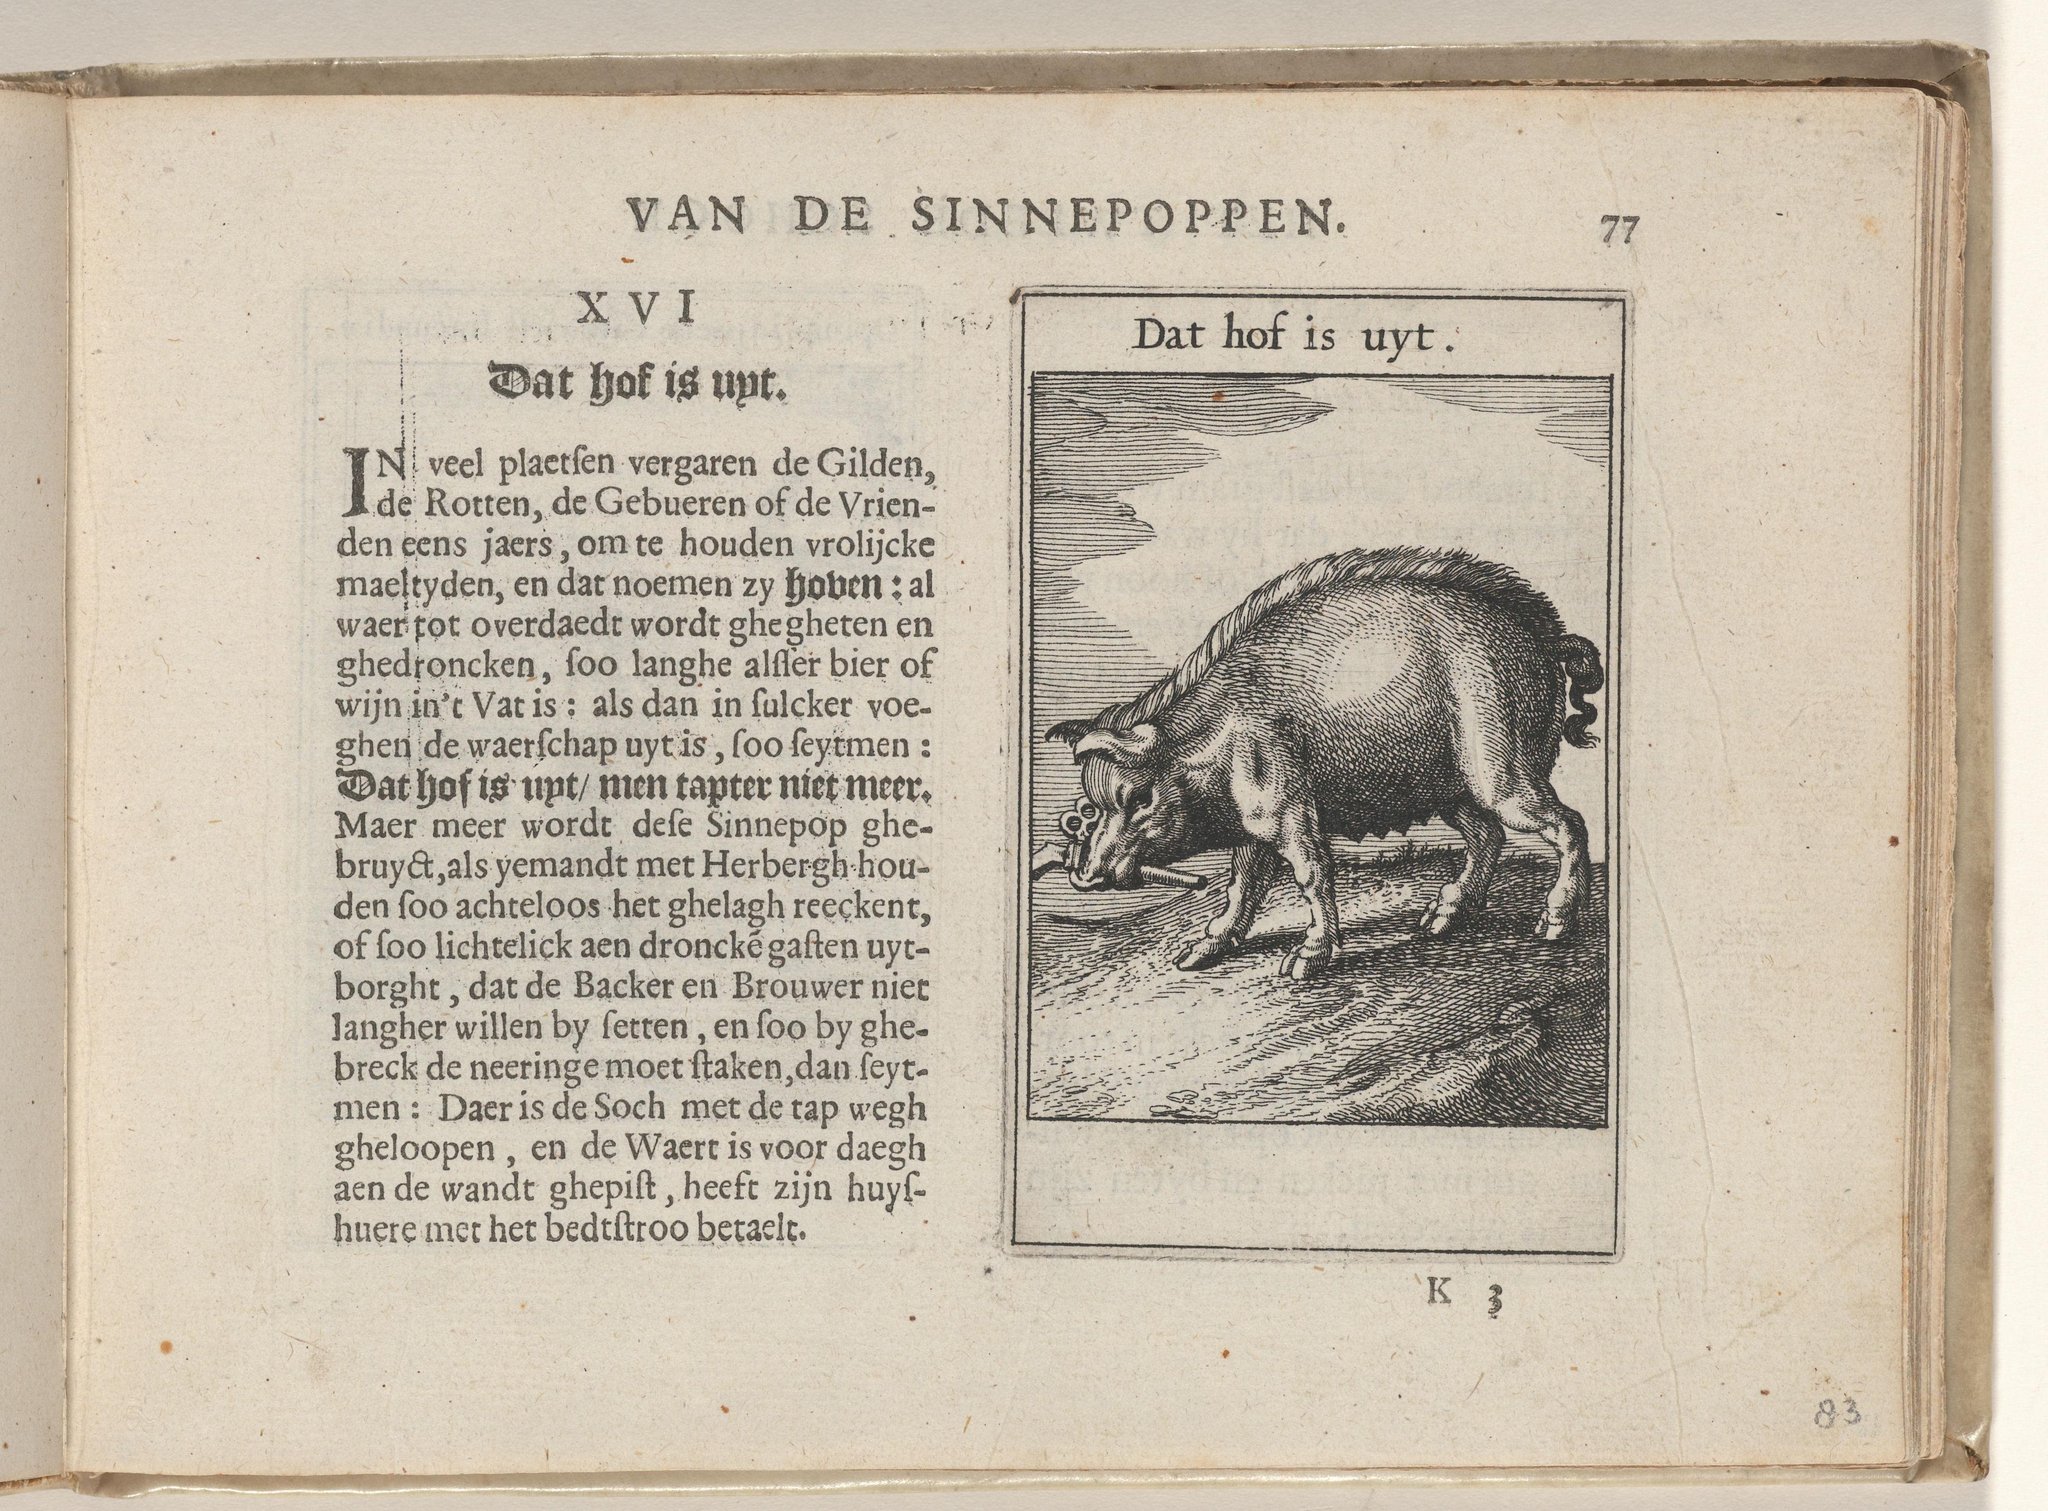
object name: album leaf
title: XVI Dat hof is uyt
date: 1614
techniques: engraving, printing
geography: the hague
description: XVI Dat hof is uyt. Tweede schok. Onderdeel van 'Sinnepoppen', R. Visscher, 1614.